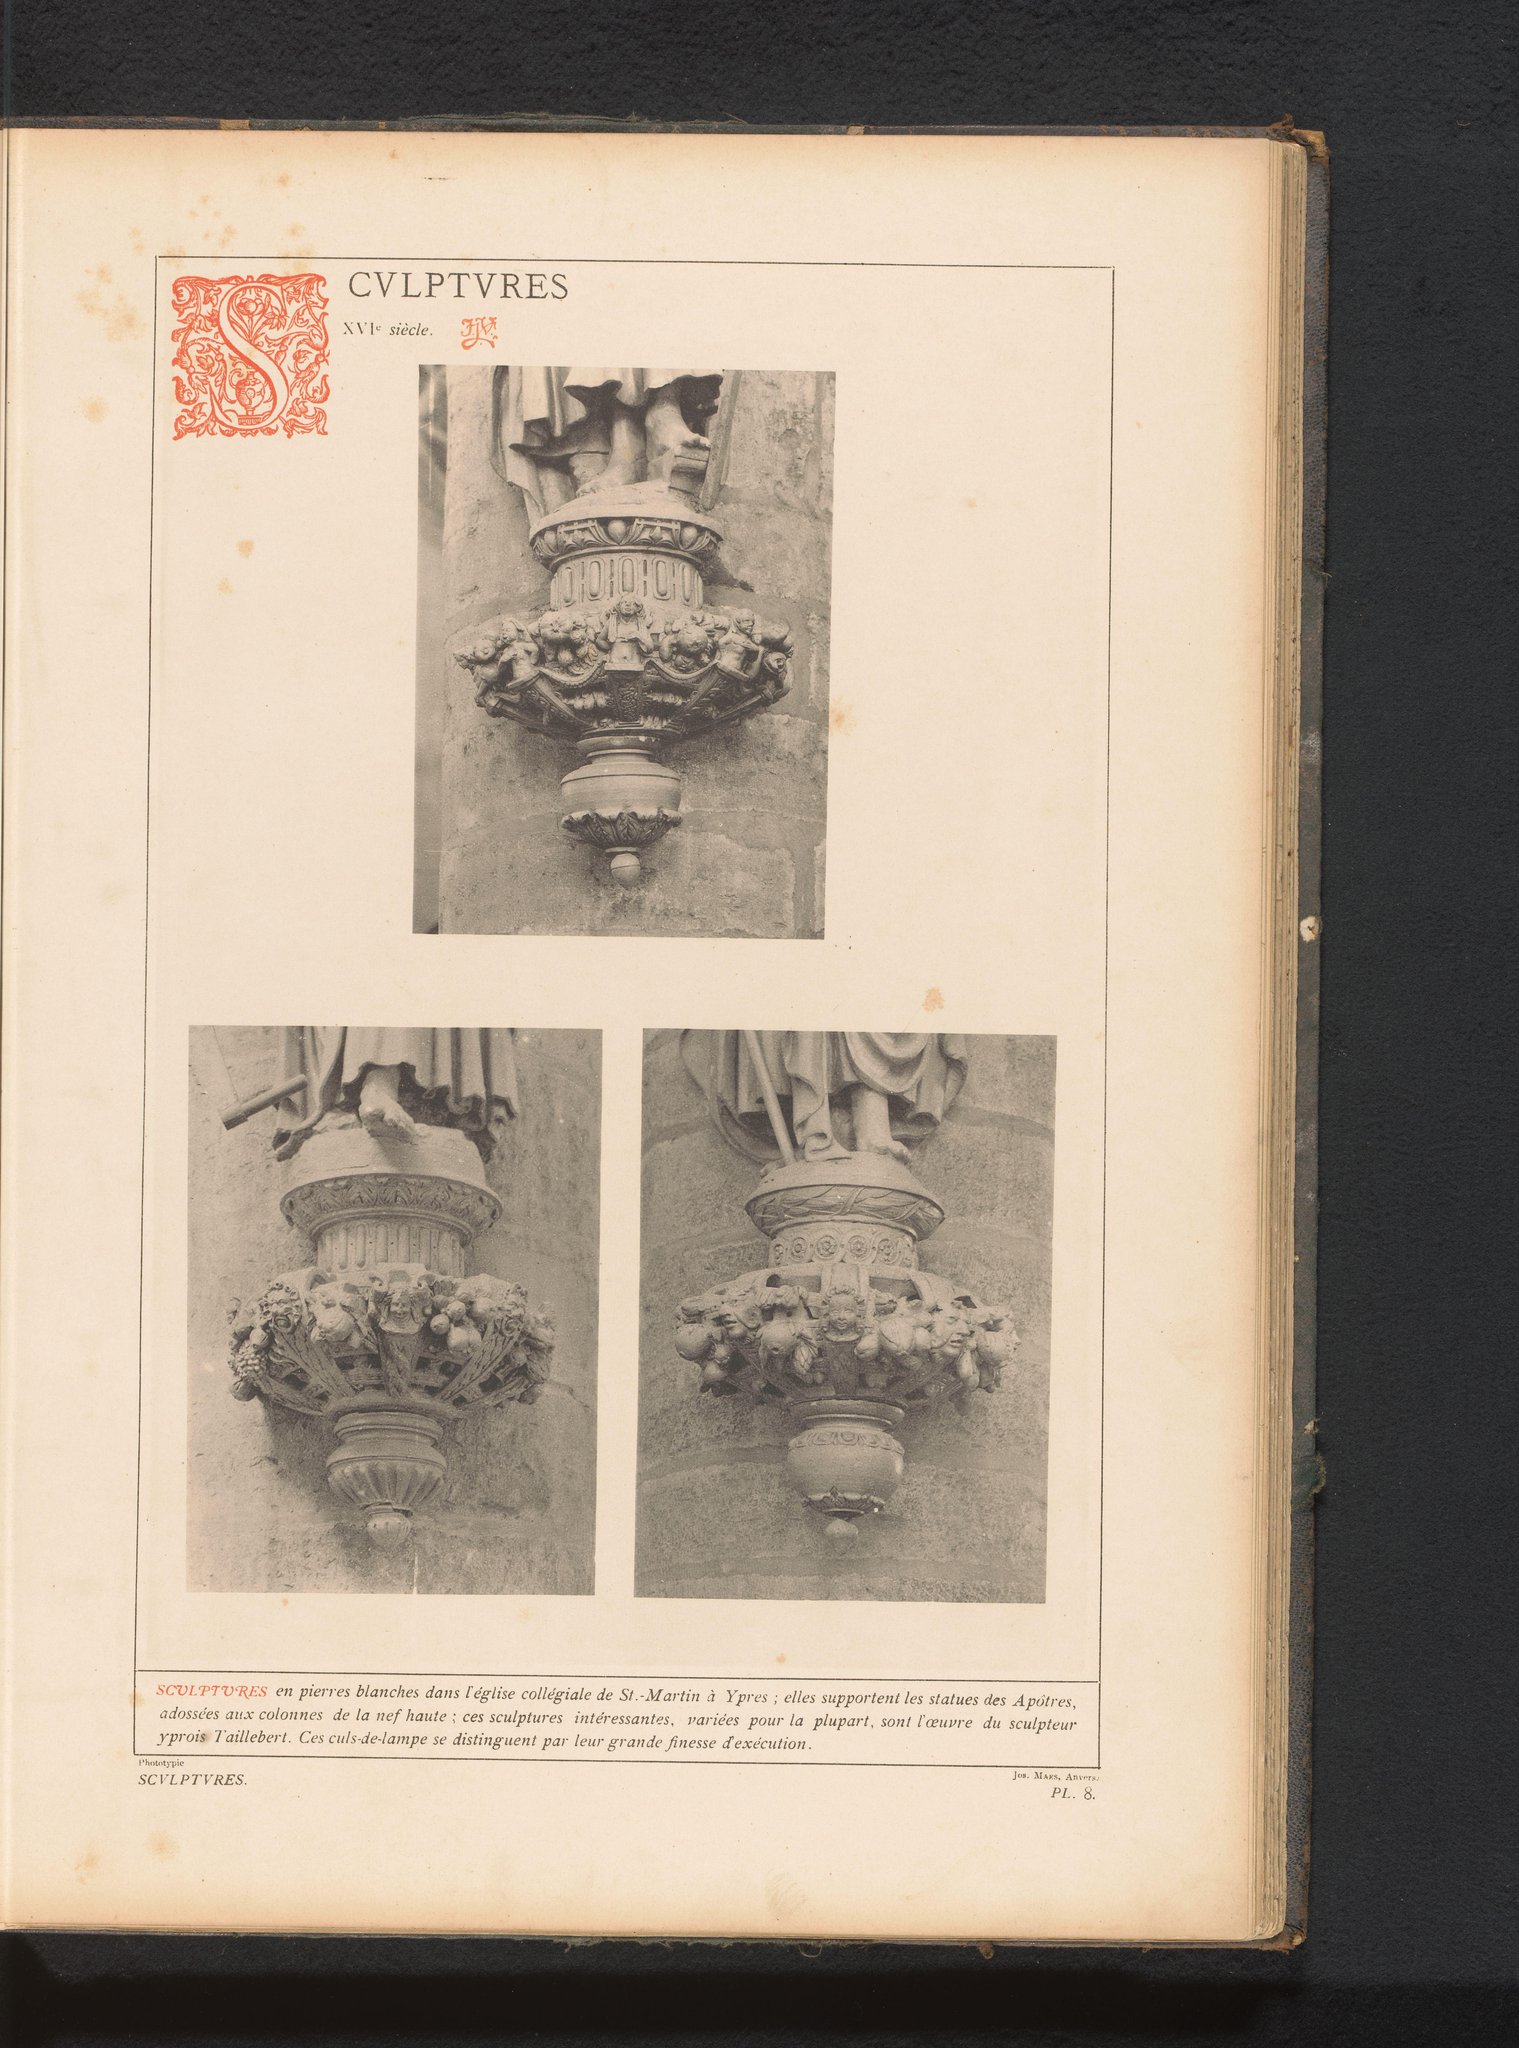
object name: photomechanical print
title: Sculptures, XVIe siècle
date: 1882-1887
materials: paper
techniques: photograph, photolithography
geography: antwerp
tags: anthropomorphic ornament, interior of church, pedestal of a piece of sculpture (perhaps in the form of a herm)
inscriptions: monogram: ‘JJvY’, inscription: ‘SCULPTURES en pierres (...)’, inscription: ‘SCULPTURES. - PL. 8.’